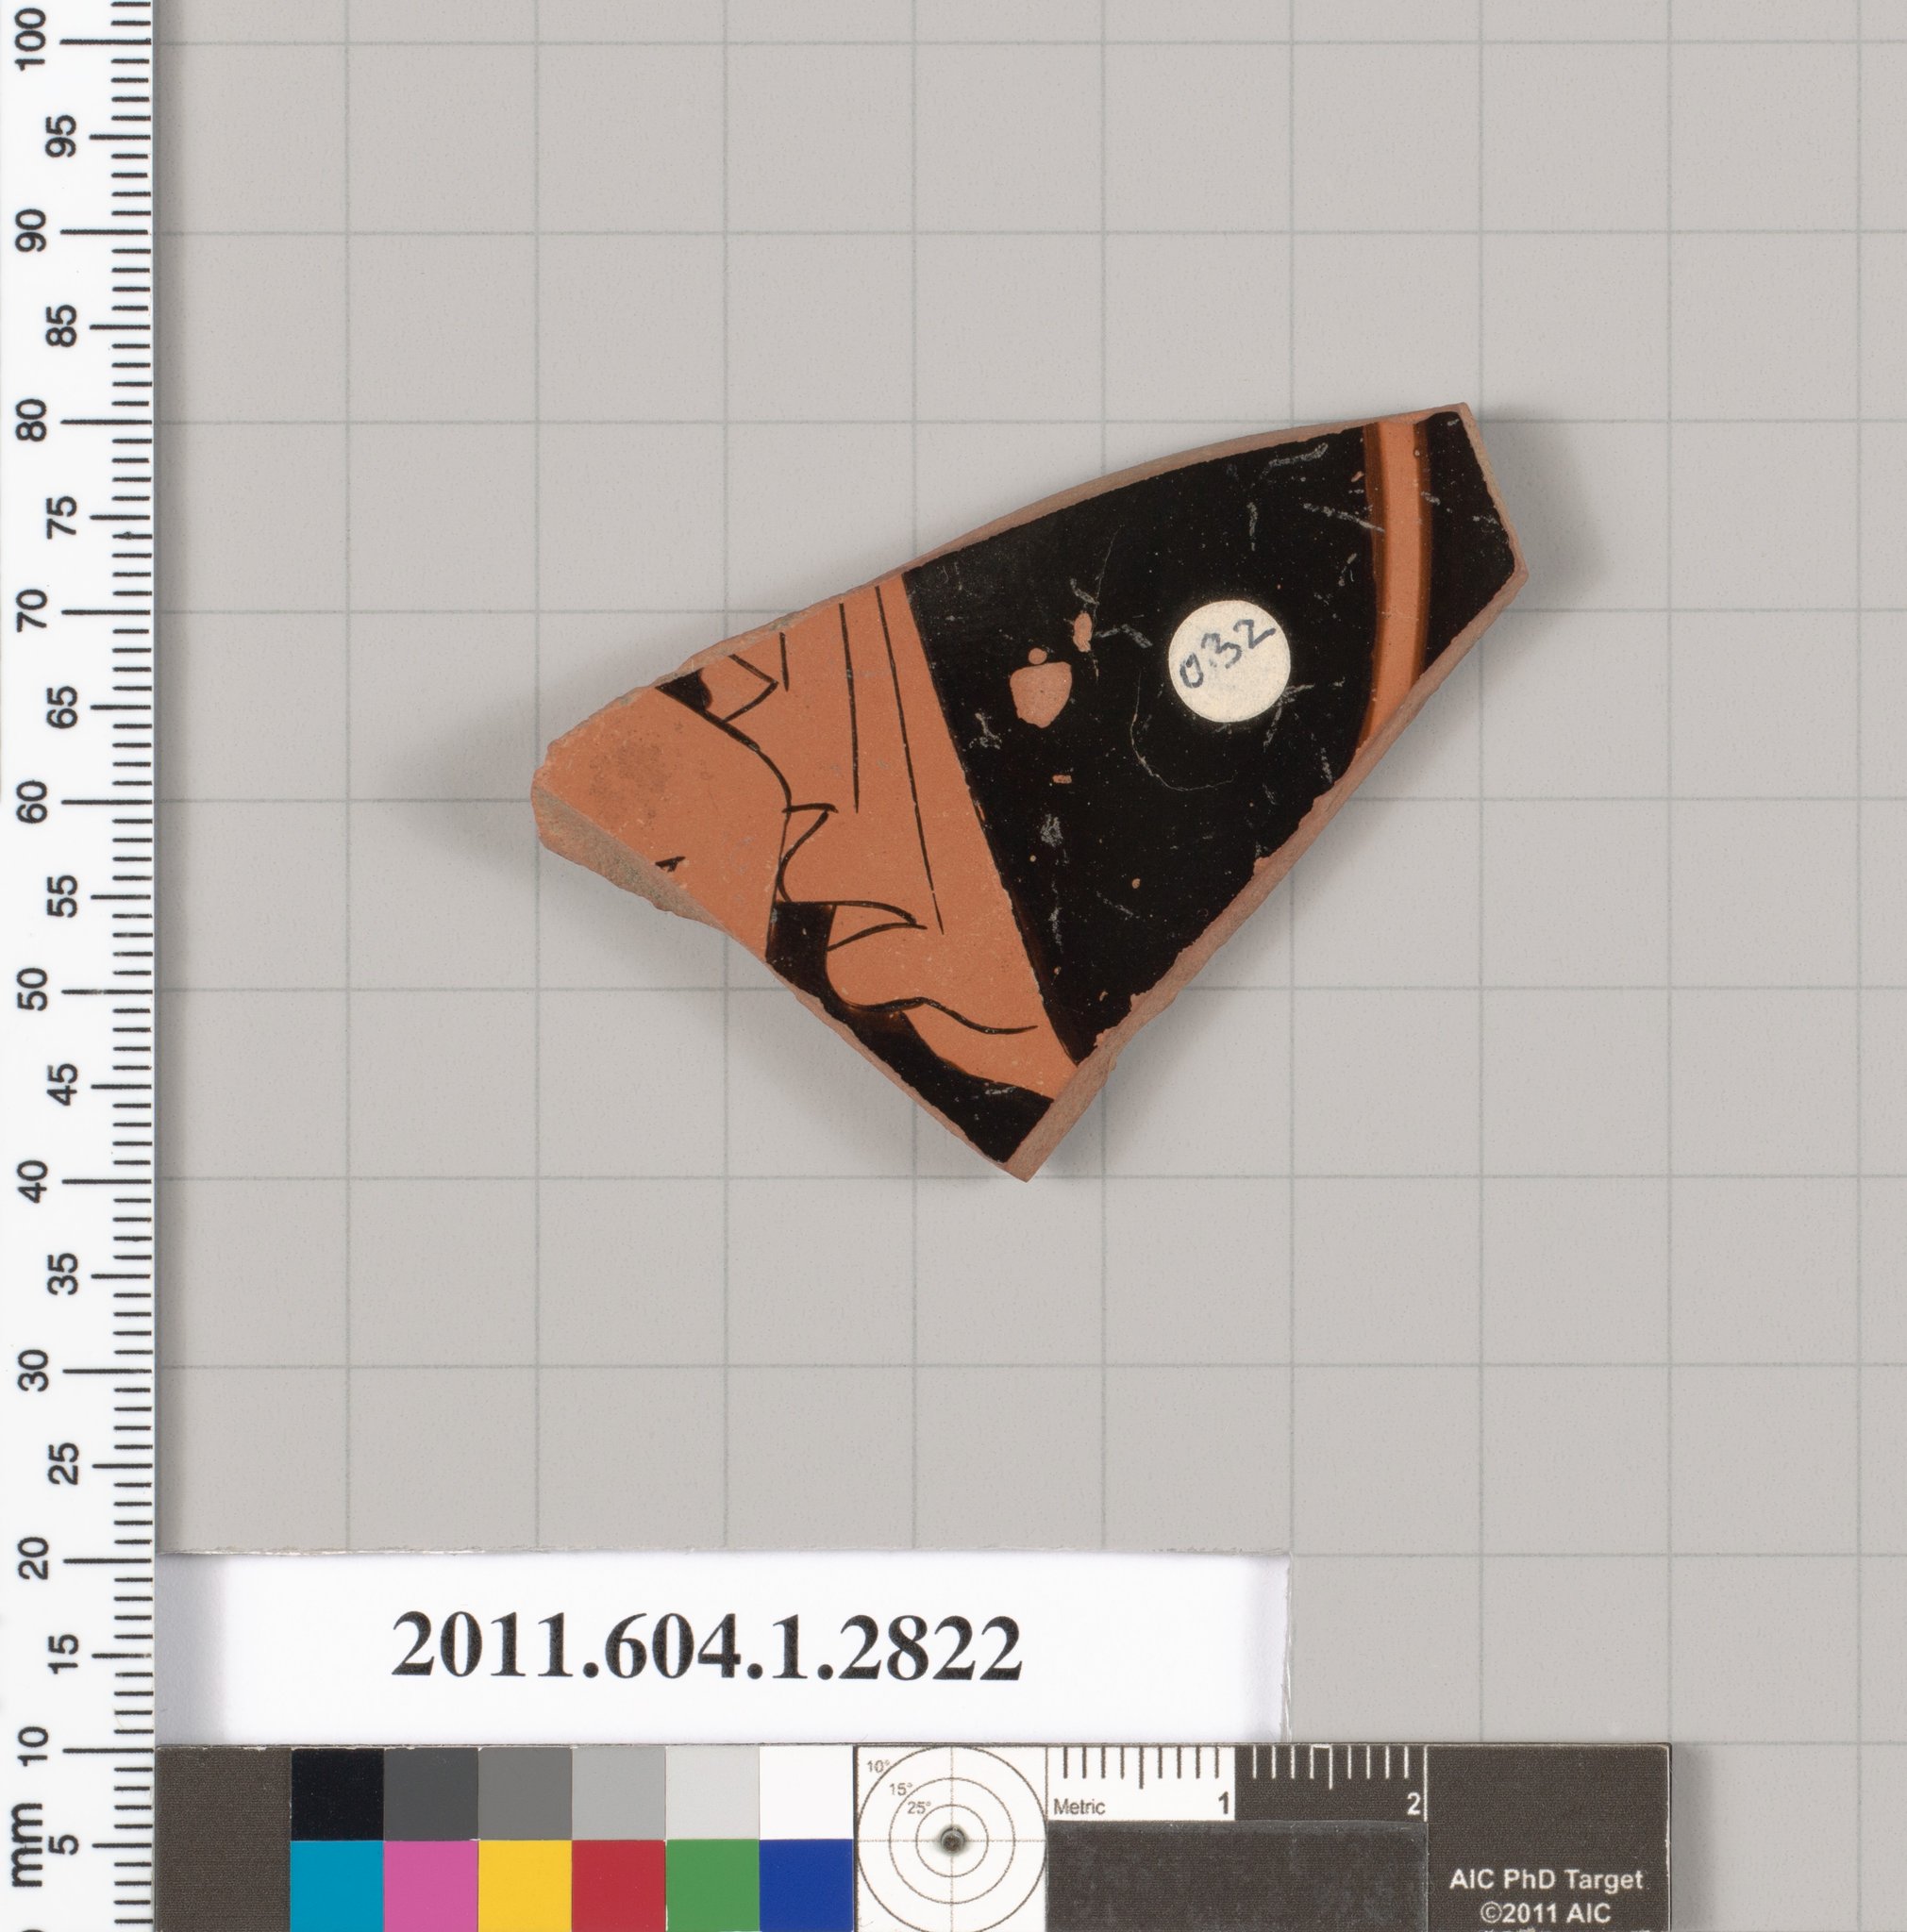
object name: kylix fragment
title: Terracotta fragment of a kylix (drinking cup)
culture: greek, attic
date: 510-490 BCE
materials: terracotta